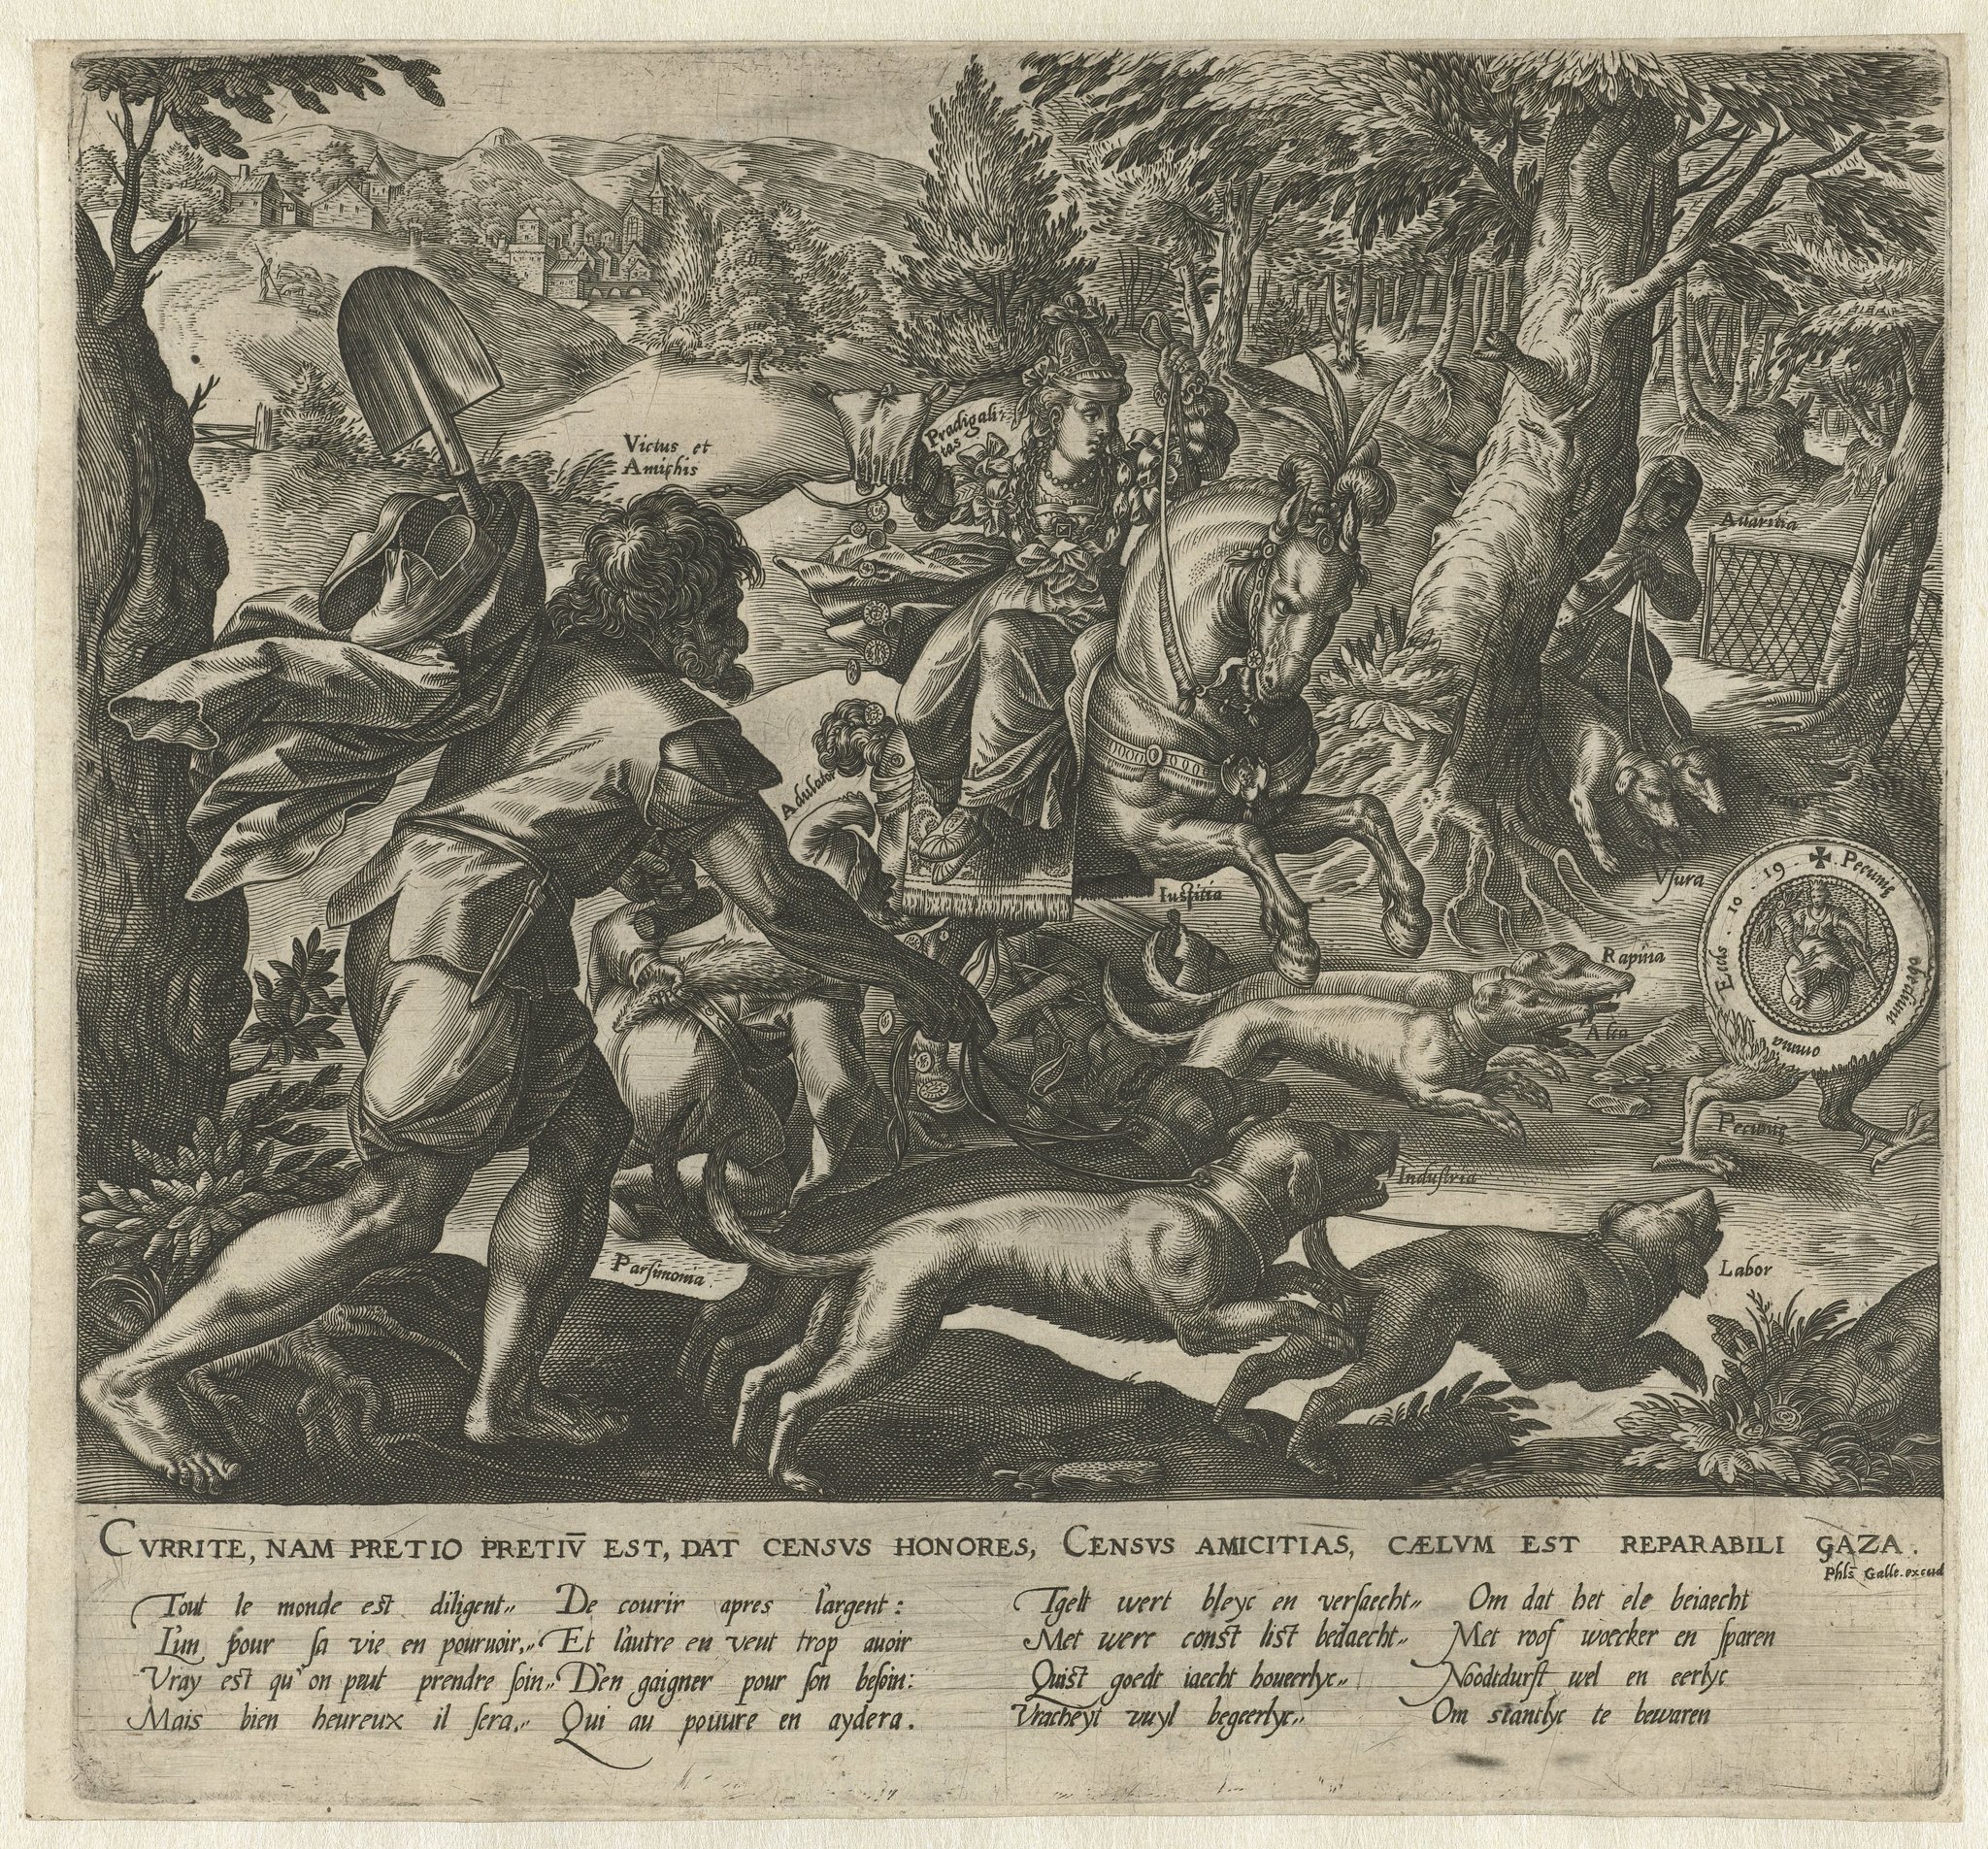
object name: print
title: Jacht op rijkdom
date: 1576-1580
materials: paper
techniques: engraving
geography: antwerp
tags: flattery; 'adulatione' (ripa), justice, 'justitia'; 'giustitia divina' (ripa) ~ one of the four cardinal virtues, hunting, chase, industriousness, assiduity; 'assiduità', 'industria', 'zelo' (ripa), covetousness; 'avaritia' (ripa) ~ personification of one of the seven deadly sins, saving, frugality, parsimony; 'parsimonia' (ripa), luck, fortune, lot; 'fato', 'fortuna', 'fortuna aurea', 'fortuna buona', 'fortuna pacifica overo clemente', 'sorte' (ripa), squandering, extravagance, prodigality, waste; 'prodigalità' (ripa), 'pecunia' (ripa)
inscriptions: address: ‘Phls Galle. excud’, collector's mark: Lugt 2228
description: Zeer waarschijnlijk is deze prent identiek aan het exemplaar beschreven onder RP-P-1883-A-7597. Op de achterzijde is links nog heel vaag 'A 759' zichtbaar. Jacobs, G. en Klinkert, C,